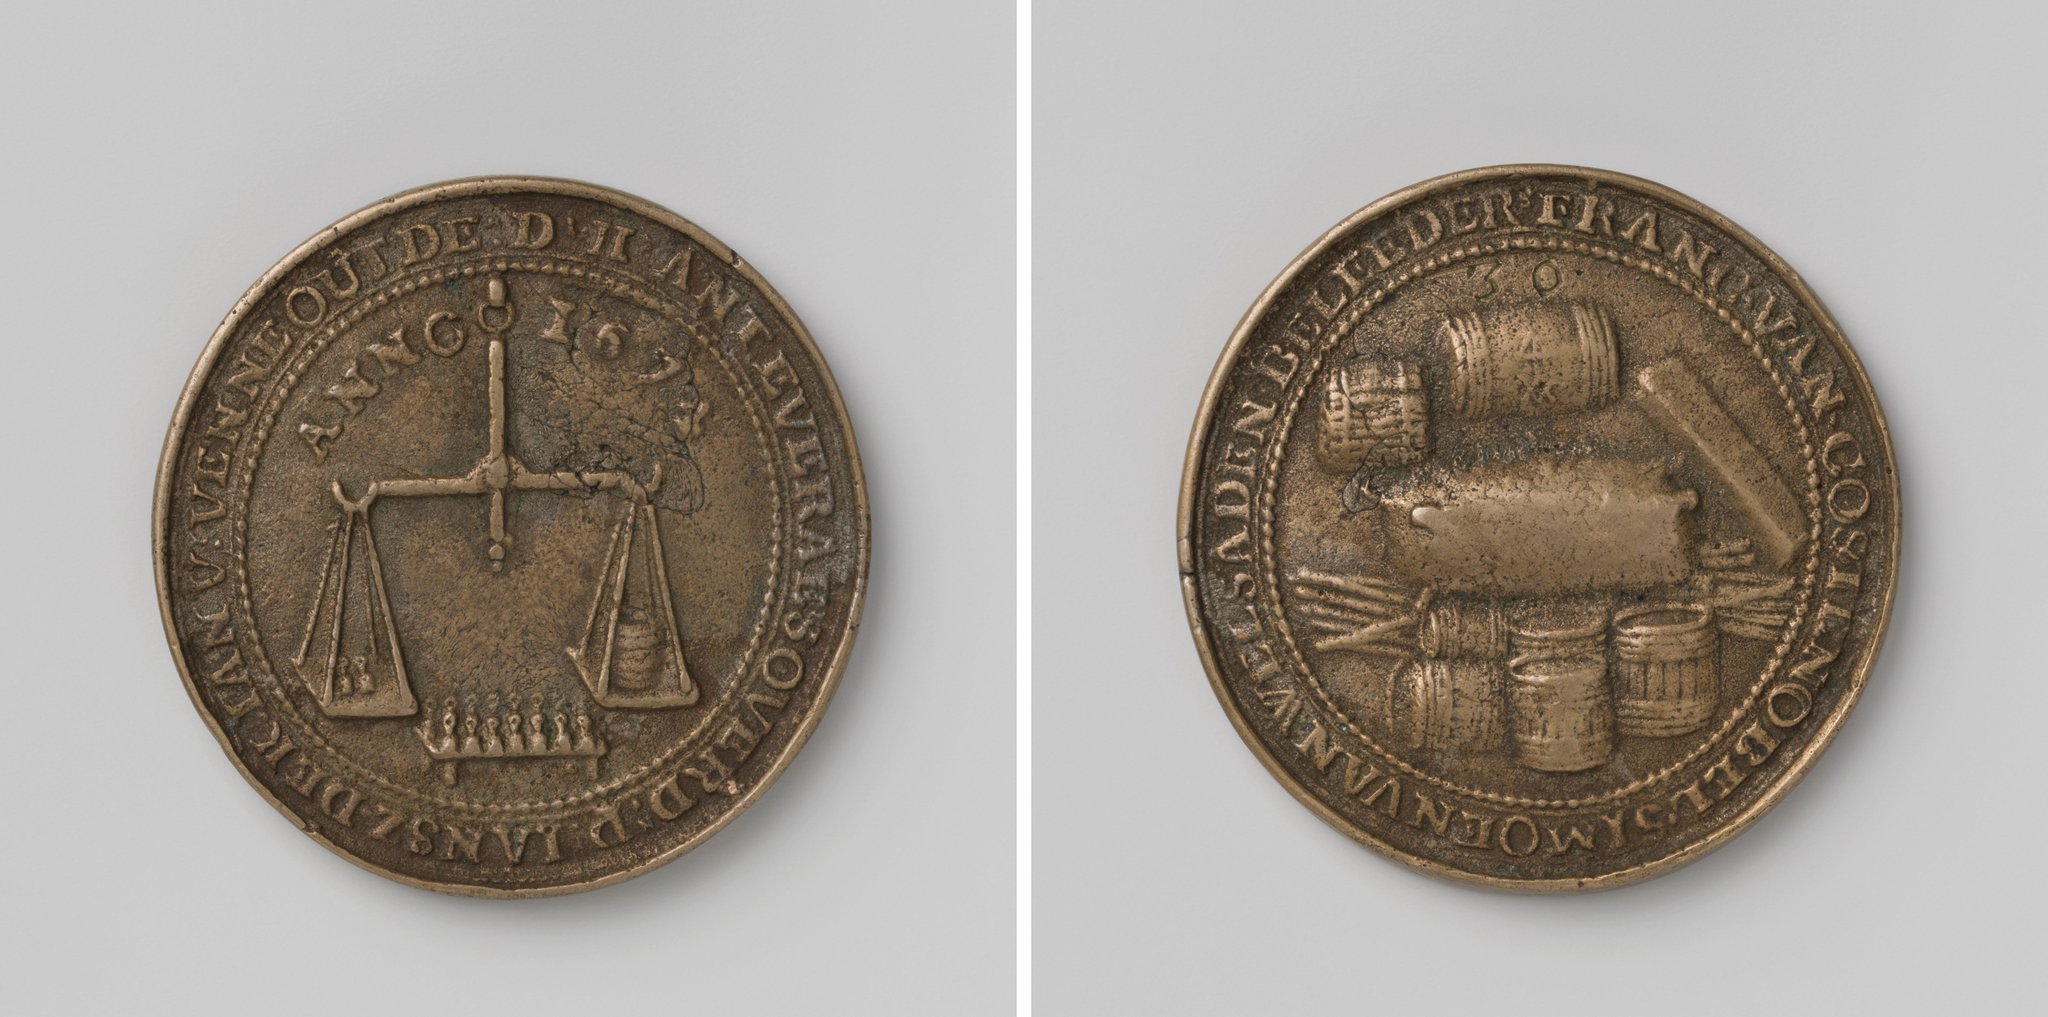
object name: medal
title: Balanskinderen- of waagwerkersgilde van Middelburg, gildepenning met no. 30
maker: Anonymous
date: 1674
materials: brass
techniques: casting, engraving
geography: middelburg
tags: middelburg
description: Messing penning. Voorzijde: onder jaartal: in evenwicht hangende weegschaal; daatussen tafeltje met gewichten binnen omschrift. Keerzijde: tonnen, vaten en balen onder cijfer 30 binnen omschrift.